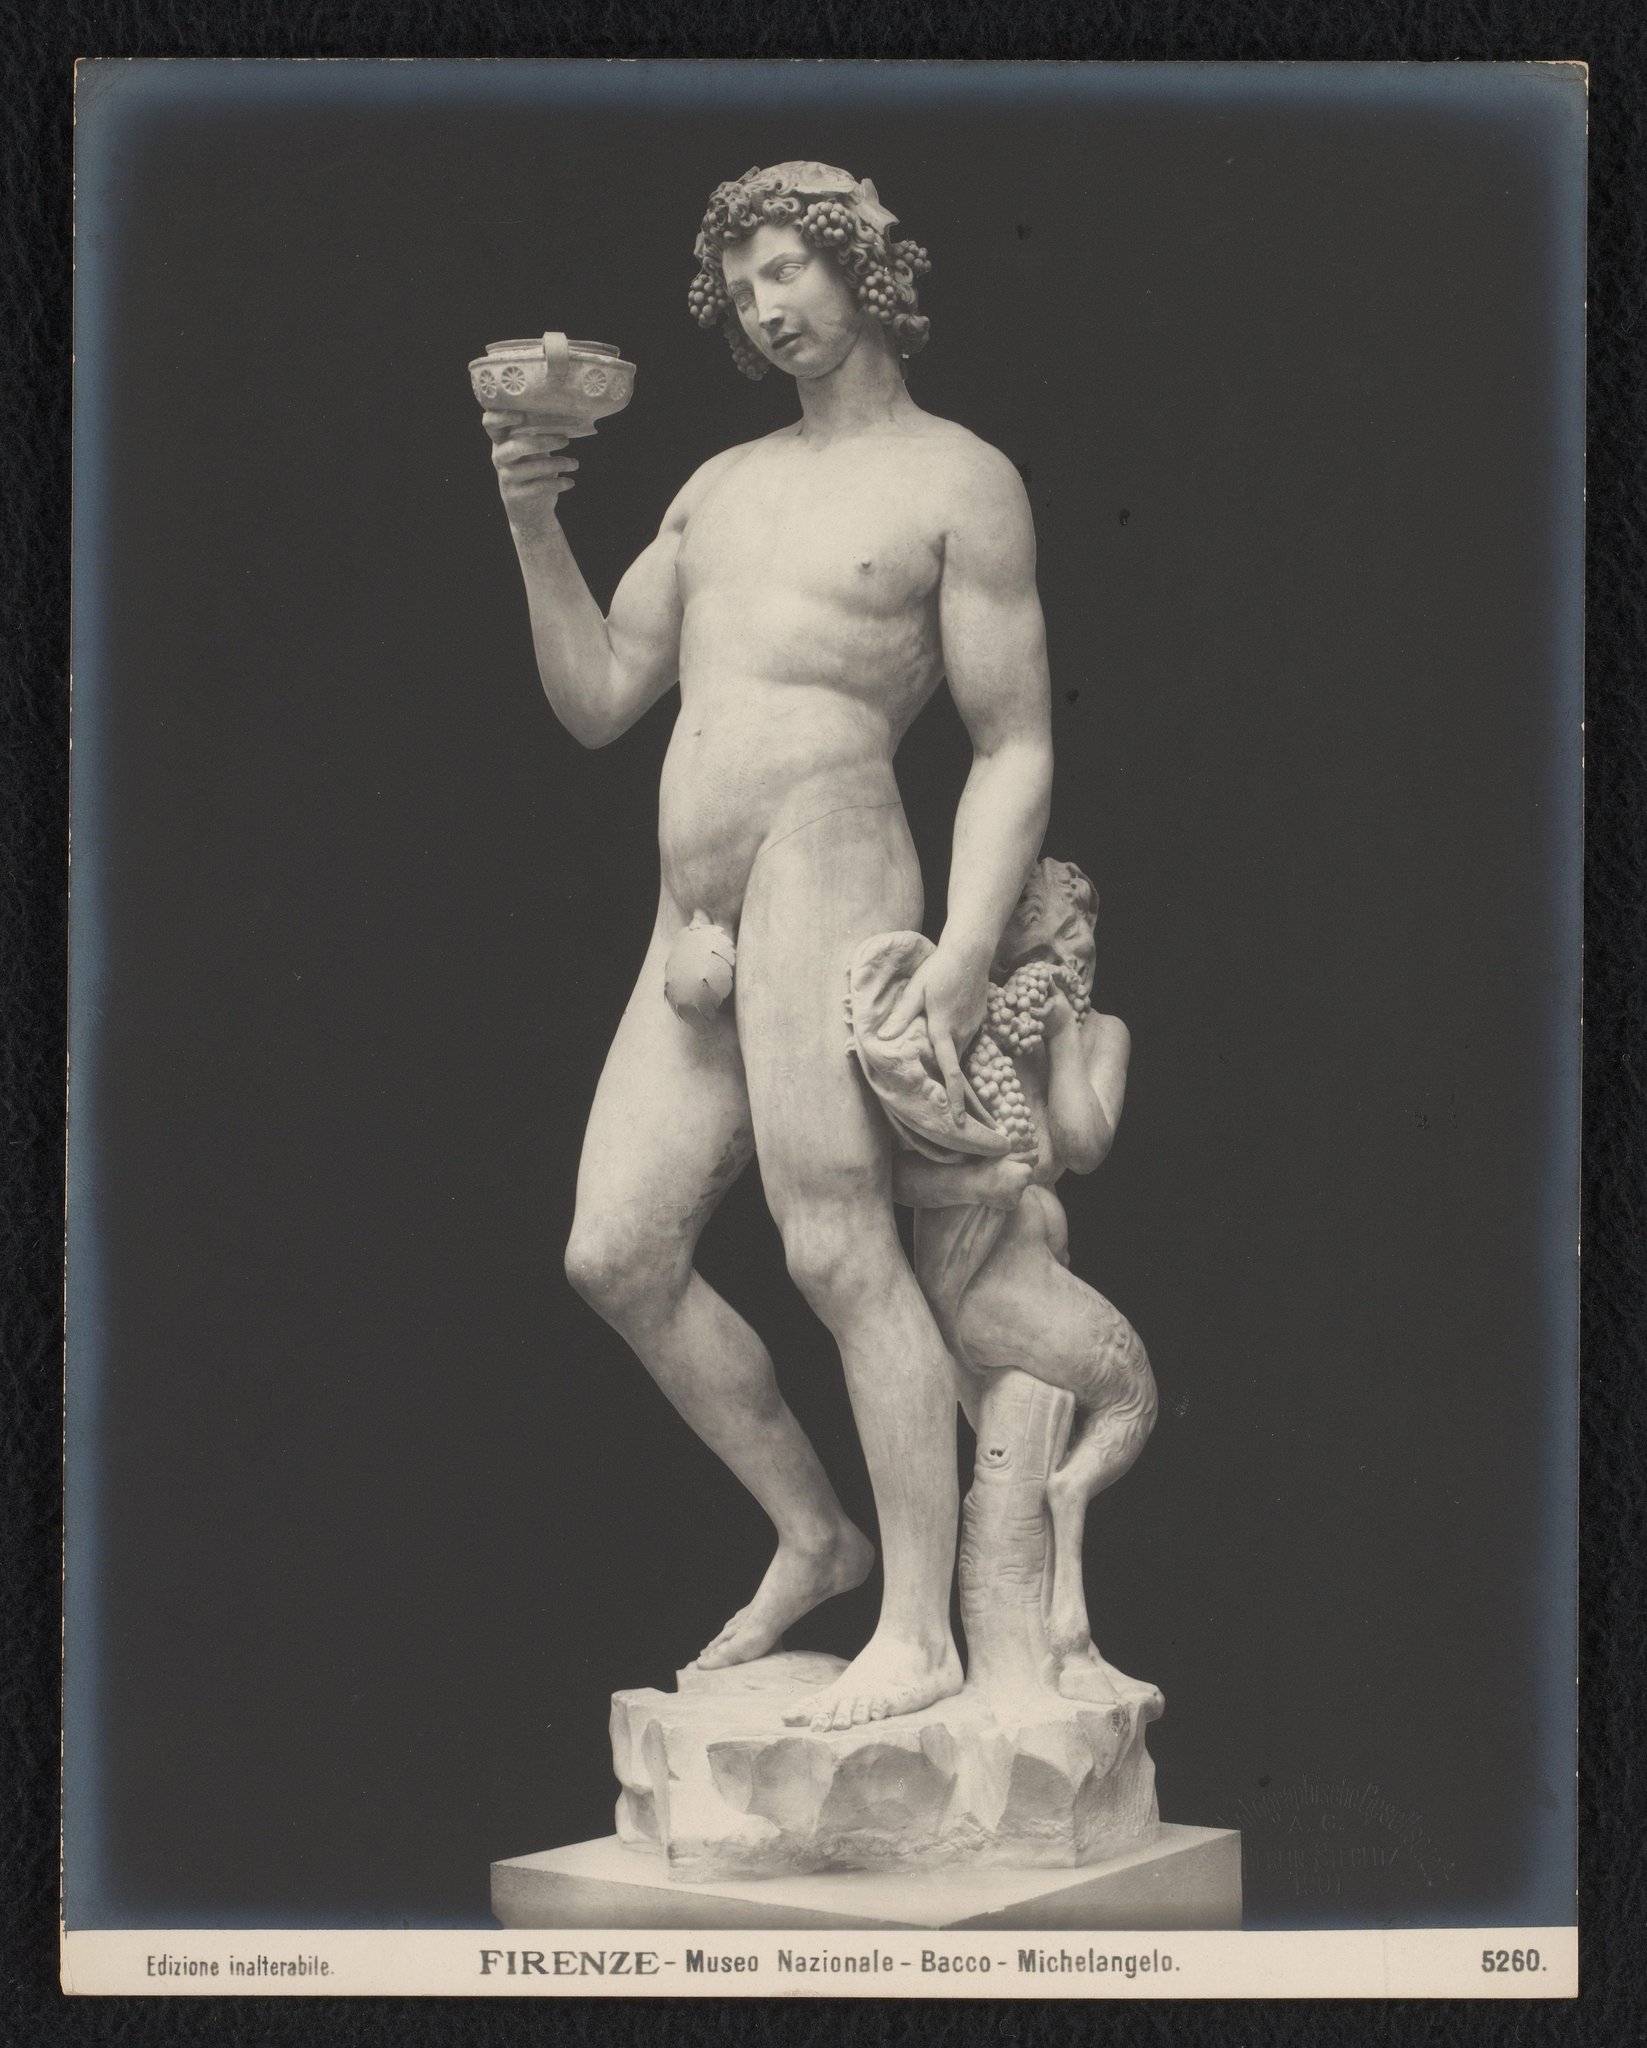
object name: photograph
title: Sculptuur van Bacchus door Michelangelo in het Museo Nazionale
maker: Anonymous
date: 1901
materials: paper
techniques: gelatin silver print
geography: florence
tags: (story of) bacchus (dionysus), liber, container of stone: stone vase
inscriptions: inscription: ‘Edizione inalterabile.’, collector's mark: ‘RIJKS SCHOOL VOOR KUNSTNIJVERHEID/ GROEP’, number: ‘5260.’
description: Deze foto maakt deel uit van een omslag.